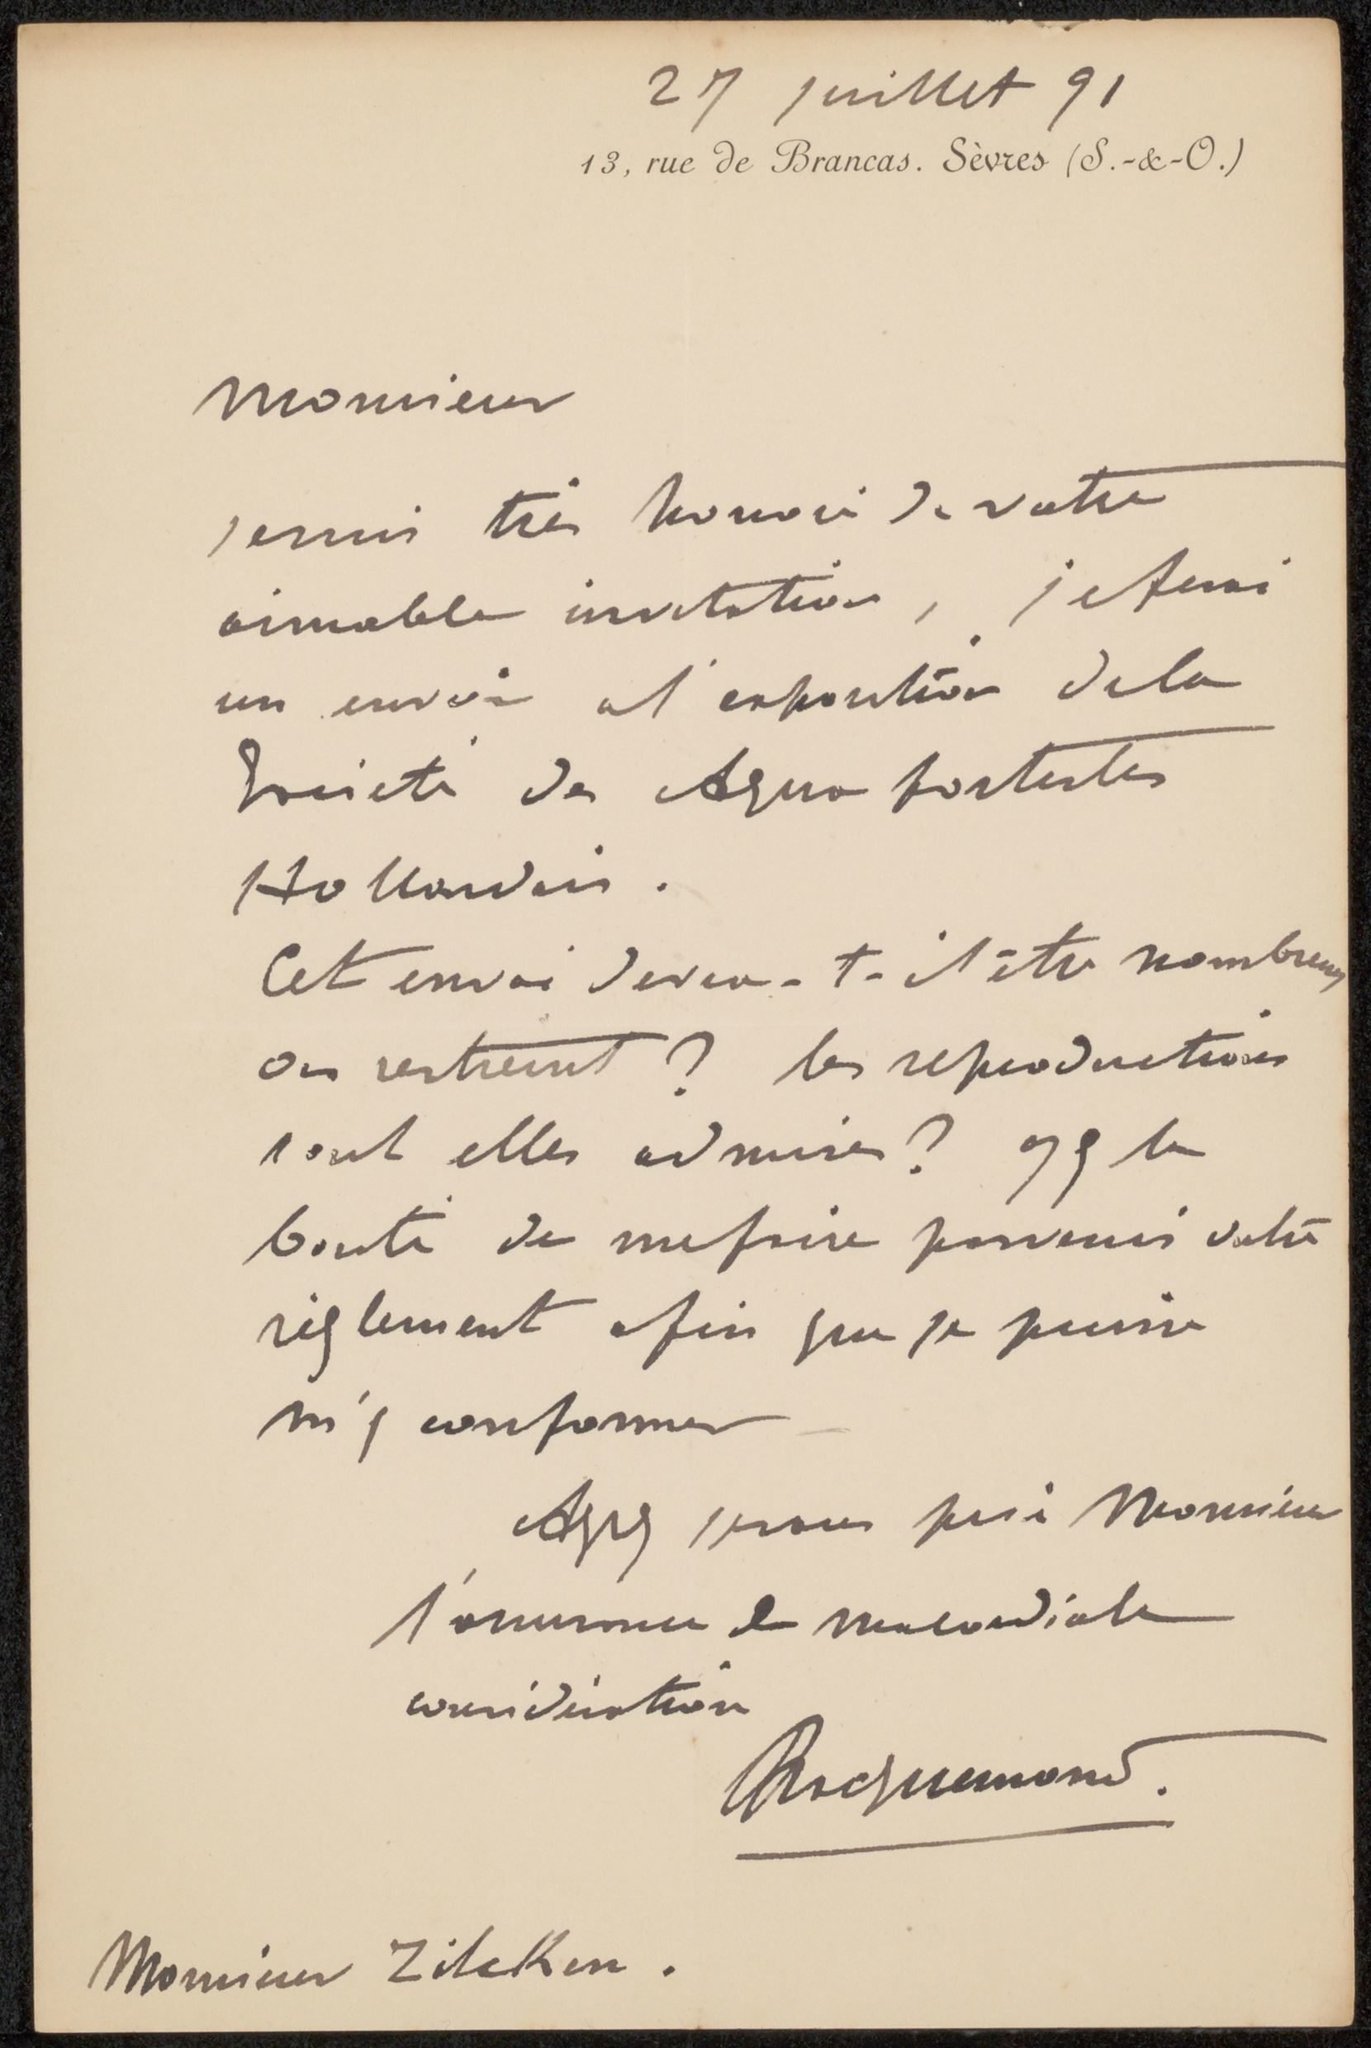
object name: letter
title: Brief aan Philip Zilcken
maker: félix bracquemond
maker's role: print maker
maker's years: 1833-1914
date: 1891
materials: ink, paper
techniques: pen, printing, writing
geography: sèvres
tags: the hague, painter, draughtsman, philip zilcken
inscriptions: collector's mark: ‘RPK’